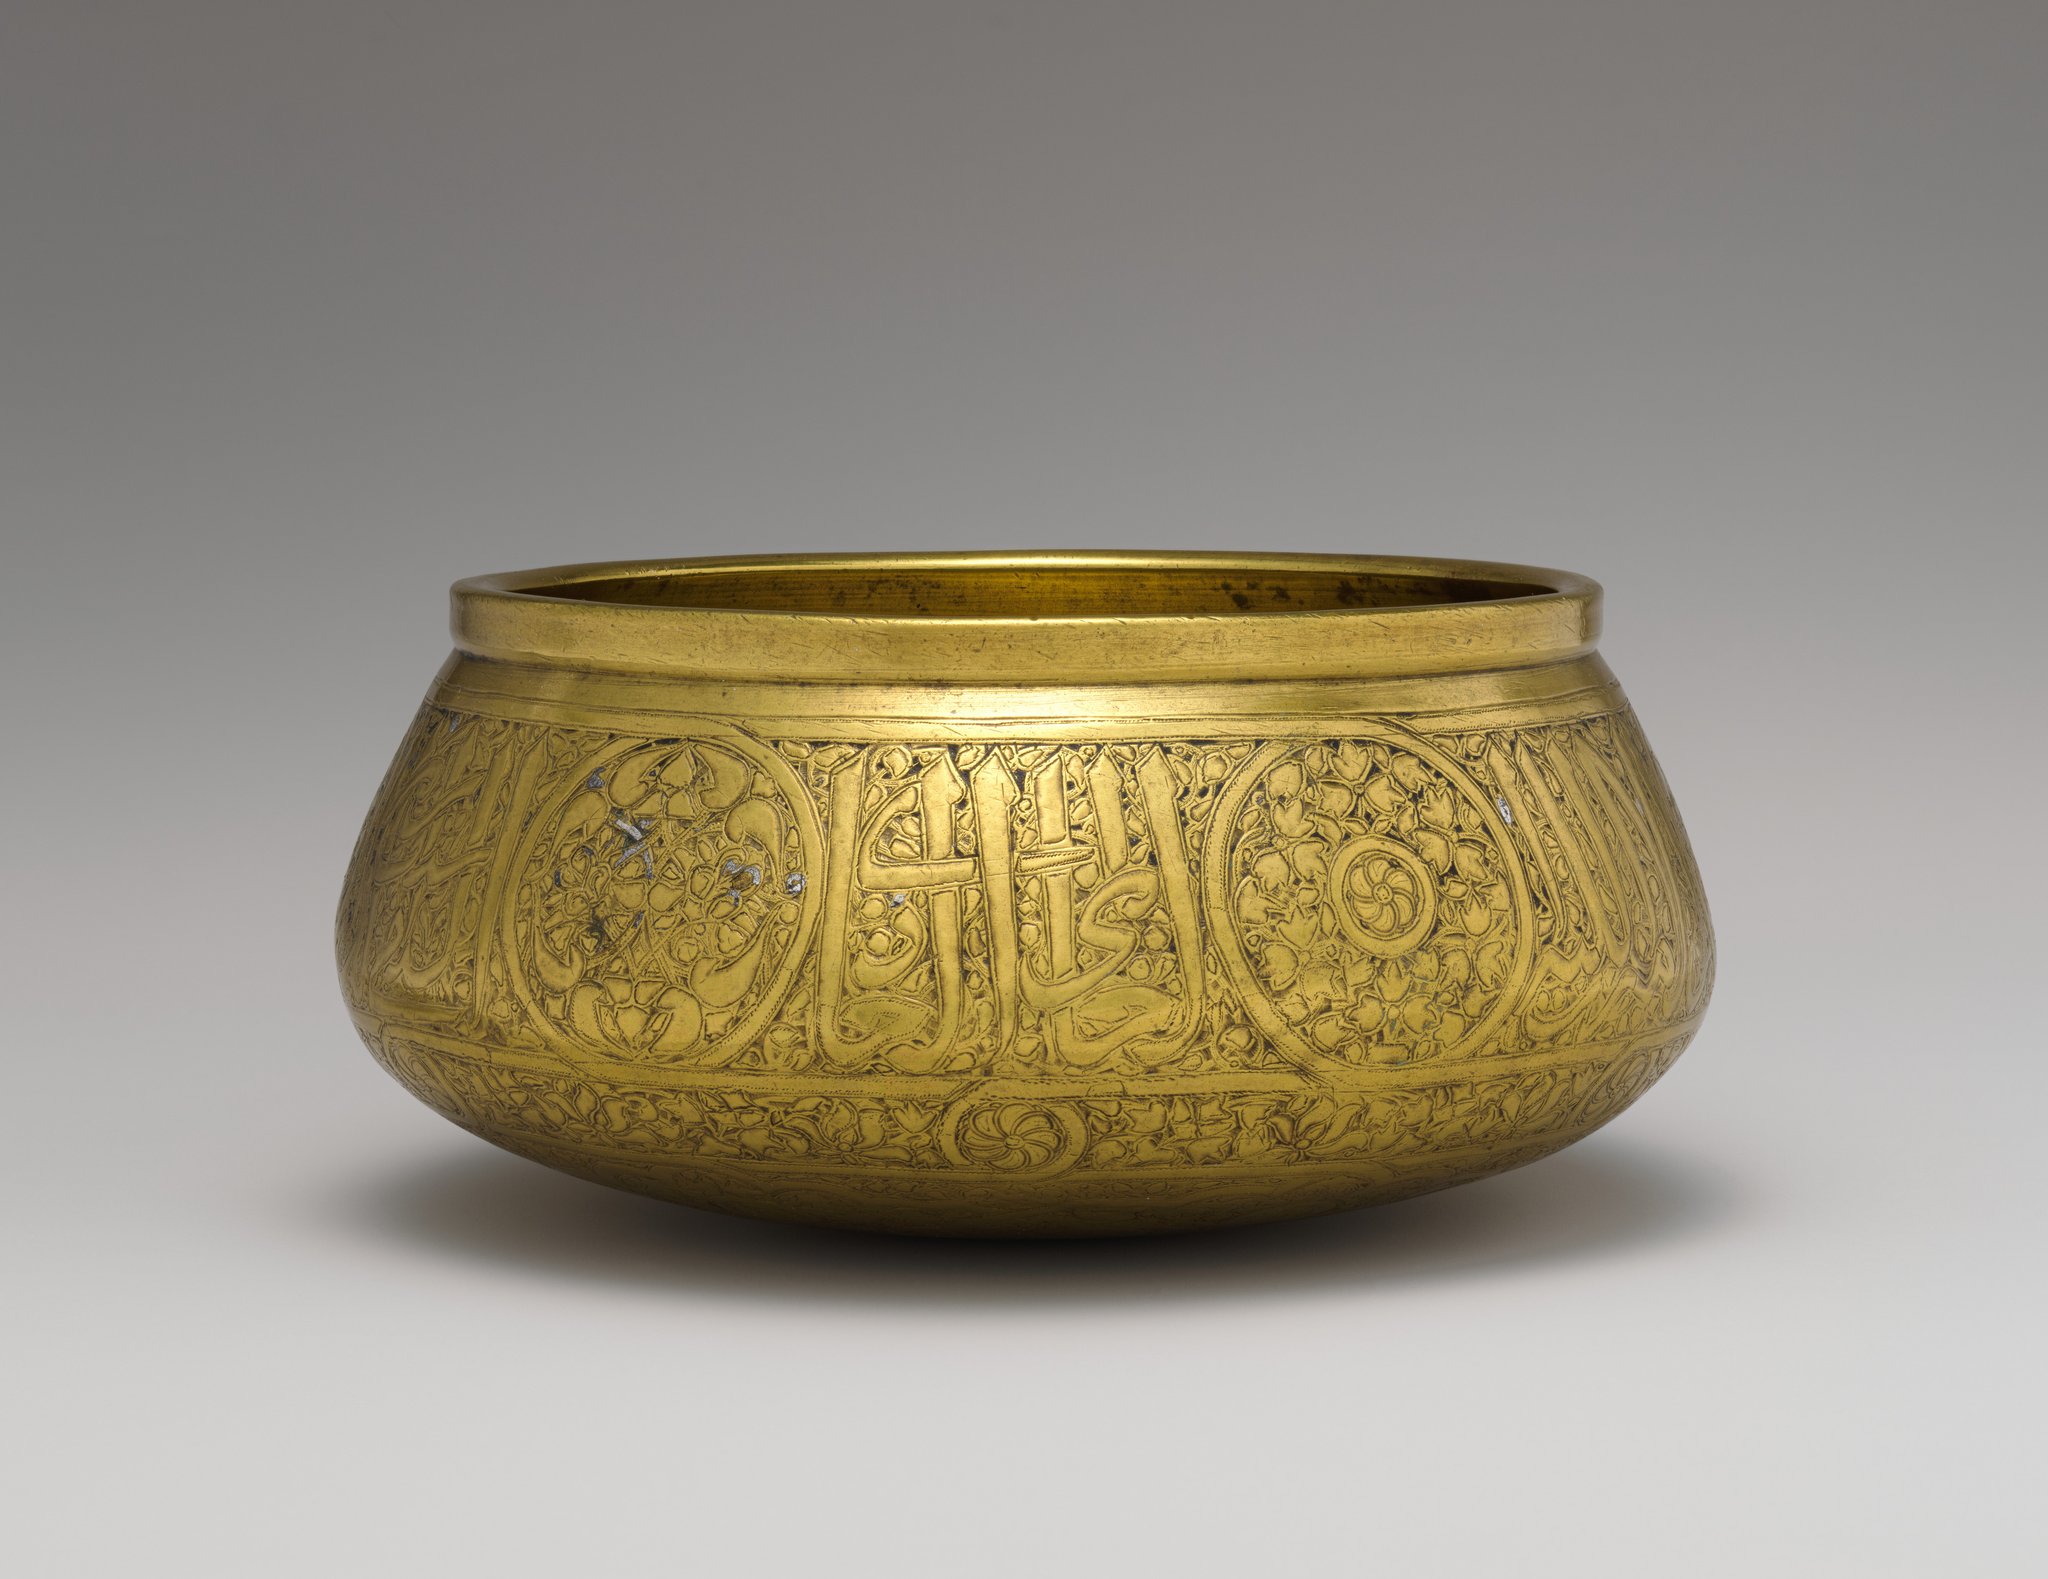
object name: bowl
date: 1301-1350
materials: brass, silver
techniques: engraving, inlay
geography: egypt or syria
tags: fish